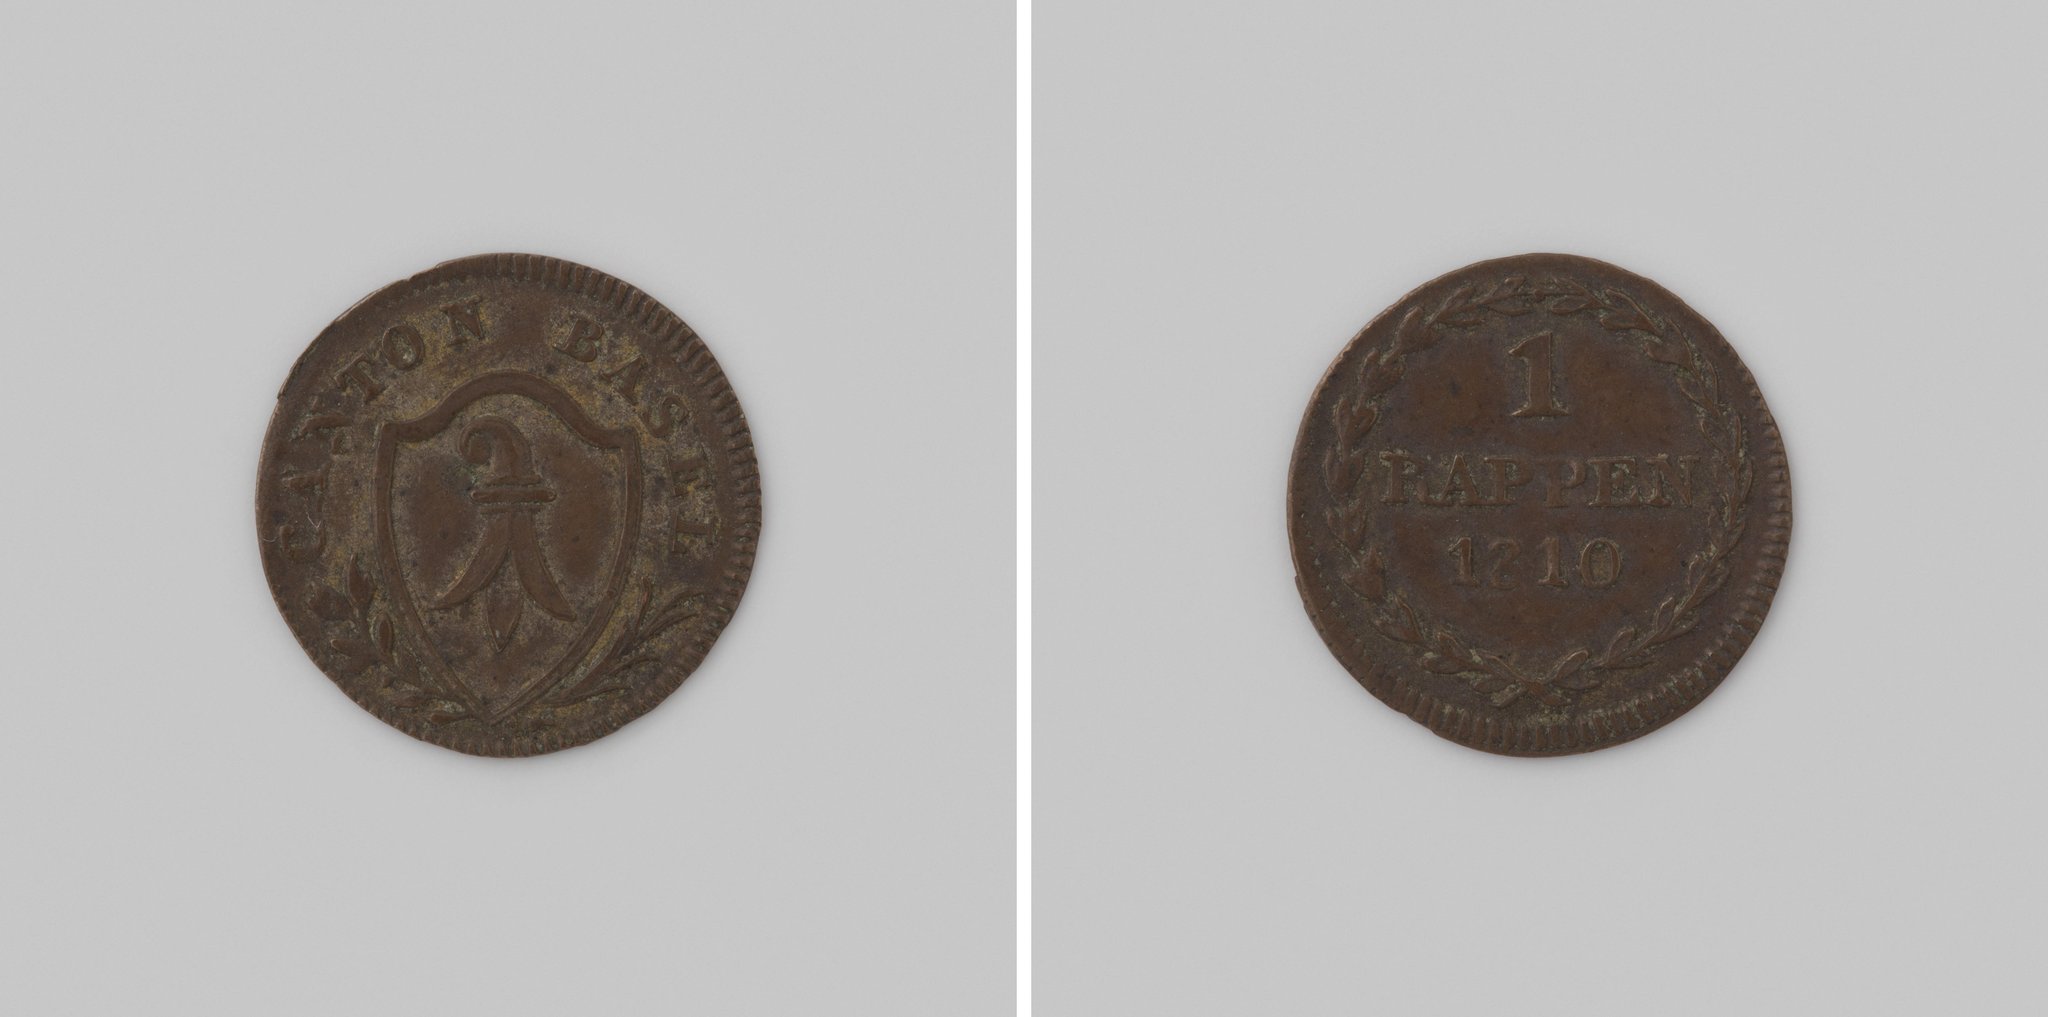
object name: coin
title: Rappen uit het kanton Bazel, 1810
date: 1810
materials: copper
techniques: striking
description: Koperen munt. Voorzijde: binnen twee takken versierd wapenschild. Keerzijde: binnen barok-versiering in twee regels waarde-aanduiding, waaronder jaartal. Gladde rand.